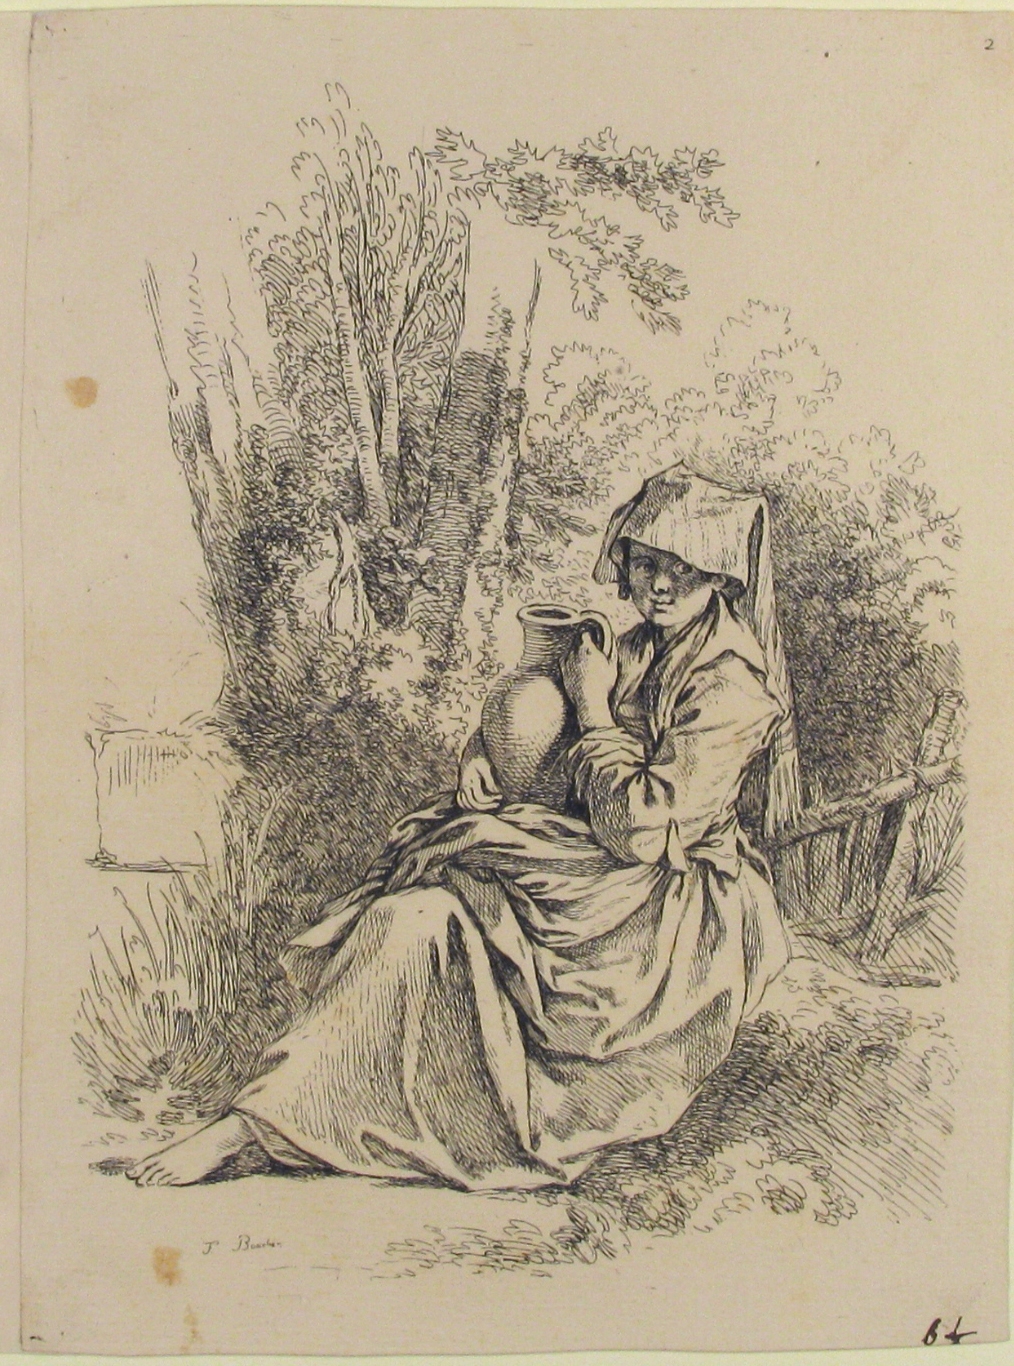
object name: print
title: Seated Young Peasant Woman Holding a Jug, from Nouveau Livre de diverse Figures (New Book of Various Figures)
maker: françois boucher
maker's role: artist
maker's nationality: french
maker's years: 1703-1770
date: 1751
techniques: etching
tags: women,jugs